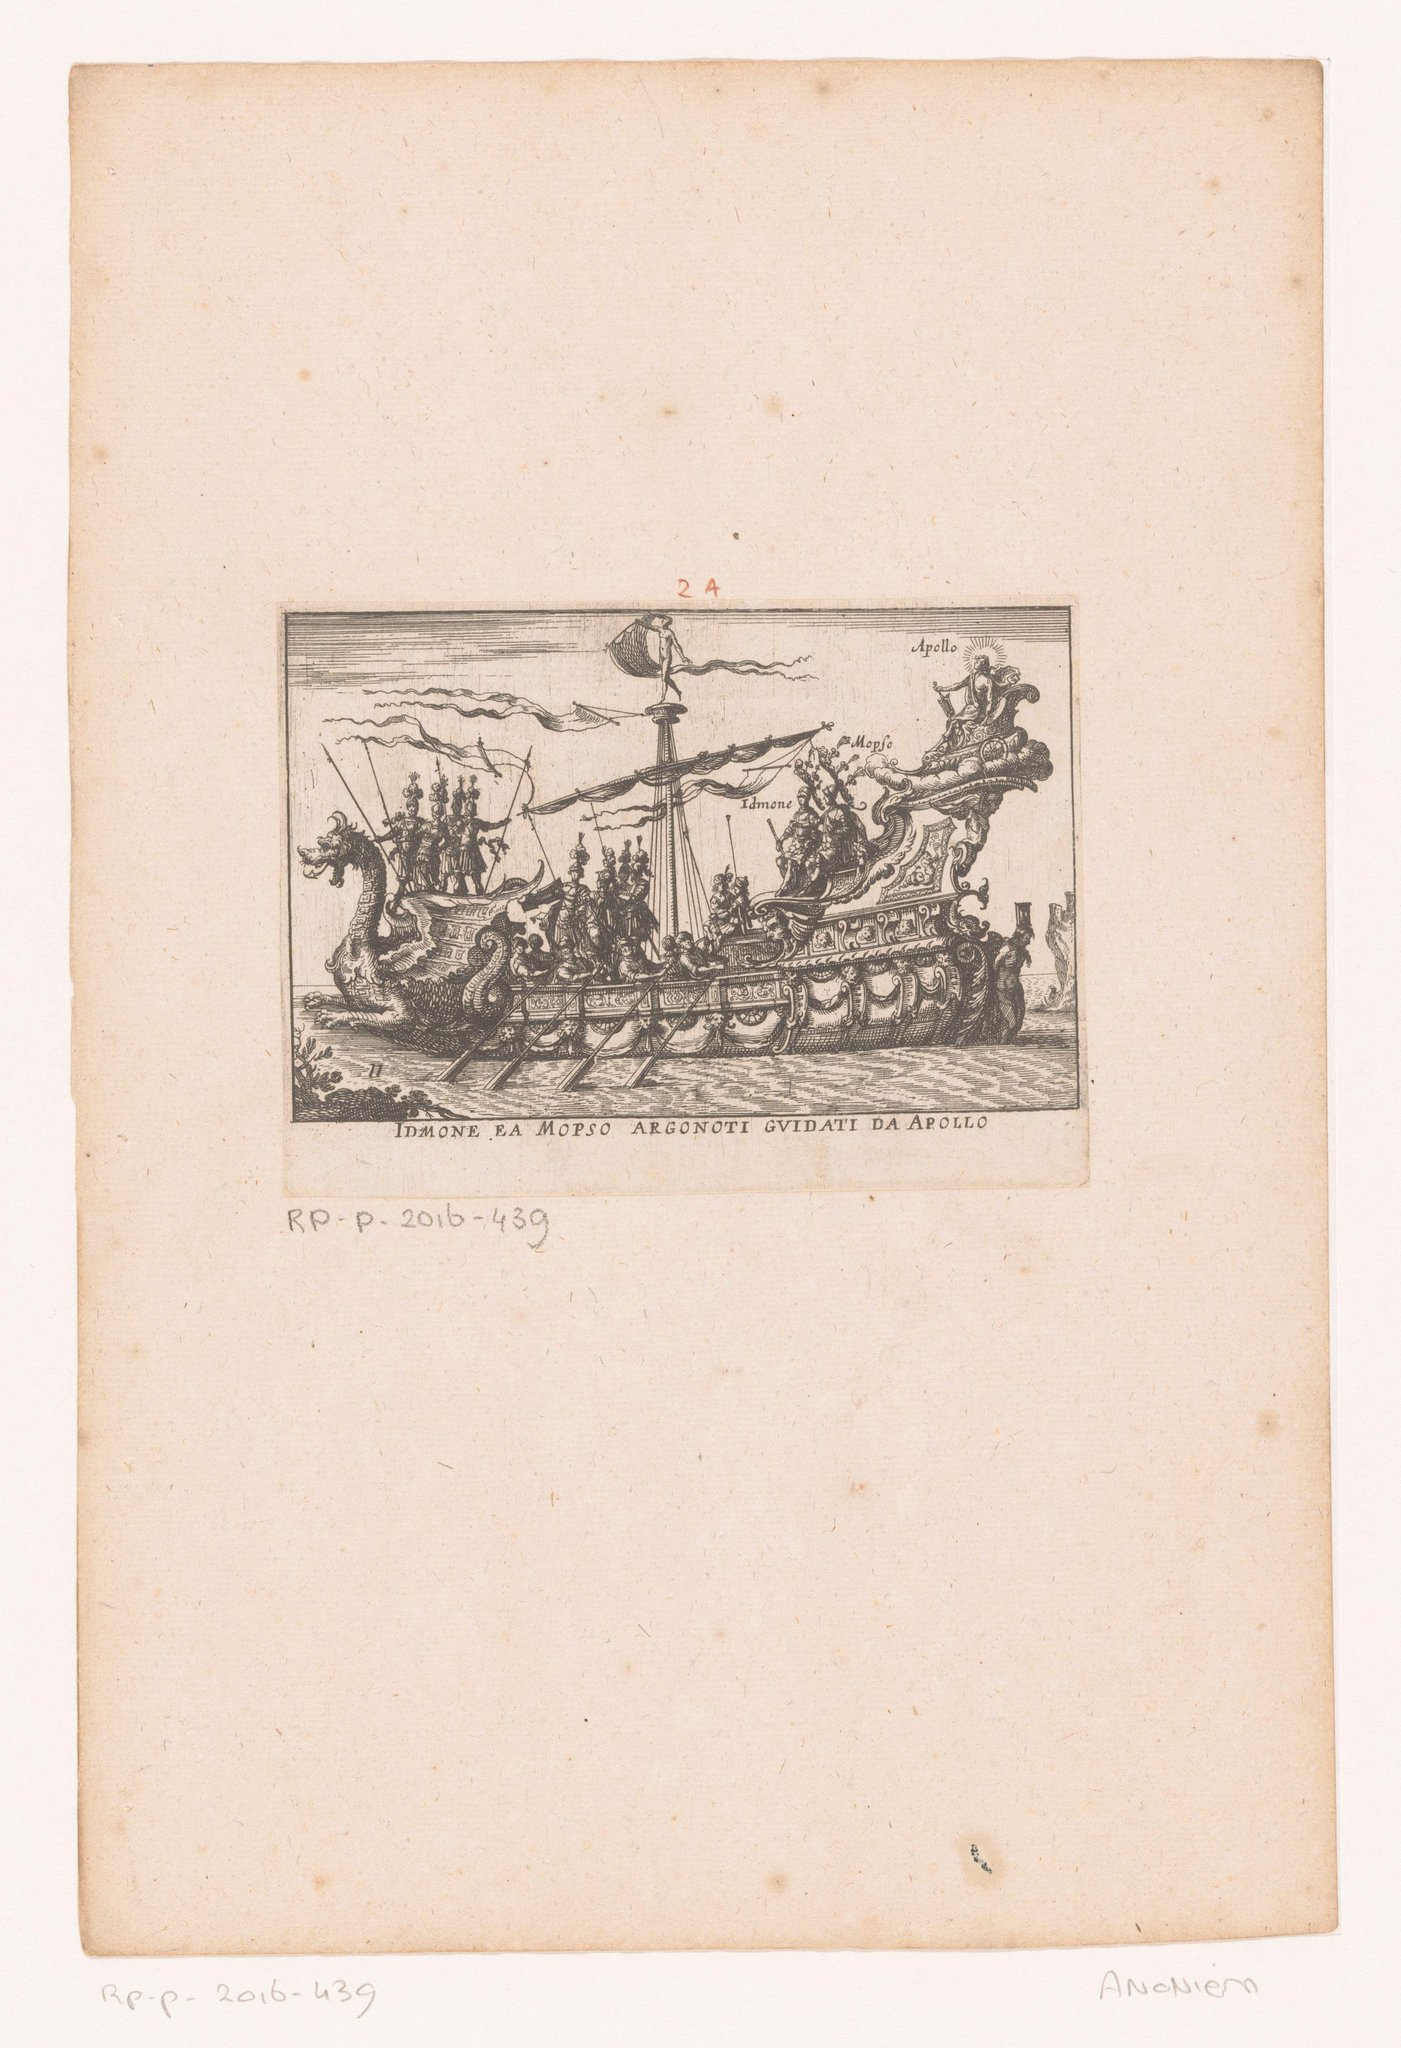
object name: print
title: Schip met Idmon, Mopsus en Apollo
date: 1624-1631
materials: paper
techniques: etching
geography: paris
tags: (story of) apollo (phoebus), ships (in general), the story of the argonauts: the quest for the golden fleece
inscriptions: collector's mark: Lugt 2228, number: ‘24’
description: Een schip met draak als boeg, op het achtersteven zitten Idmon, Mopsus en Apollo.